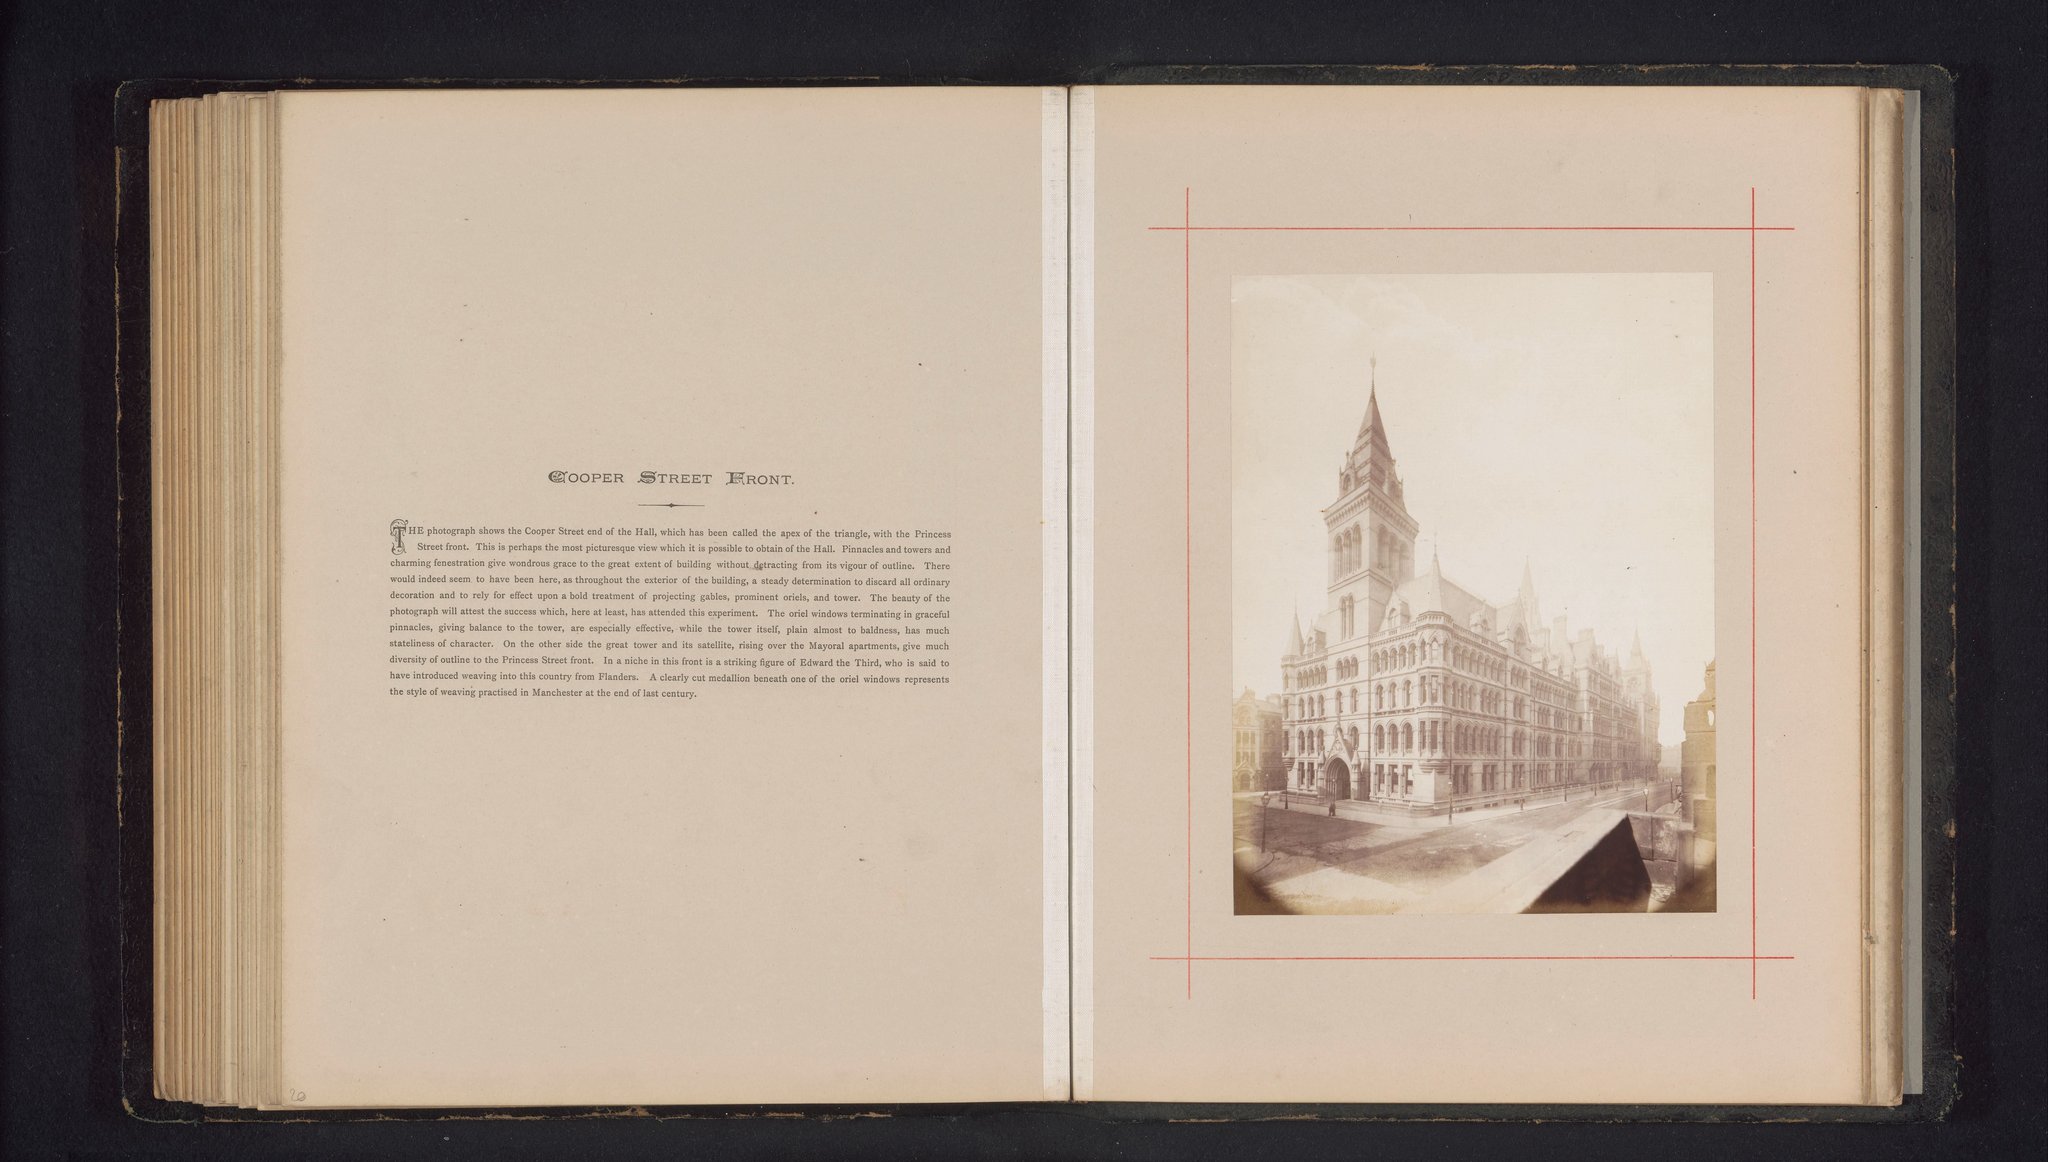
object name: page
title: Exterieur van het Stadhuis van Manchester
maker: j. mcleod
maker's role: fotograaf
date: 1877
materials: photographic support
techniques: albumen print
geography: manchester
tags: townhall, façade (of house or building)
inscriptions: title: ‘Cooper Street Front’